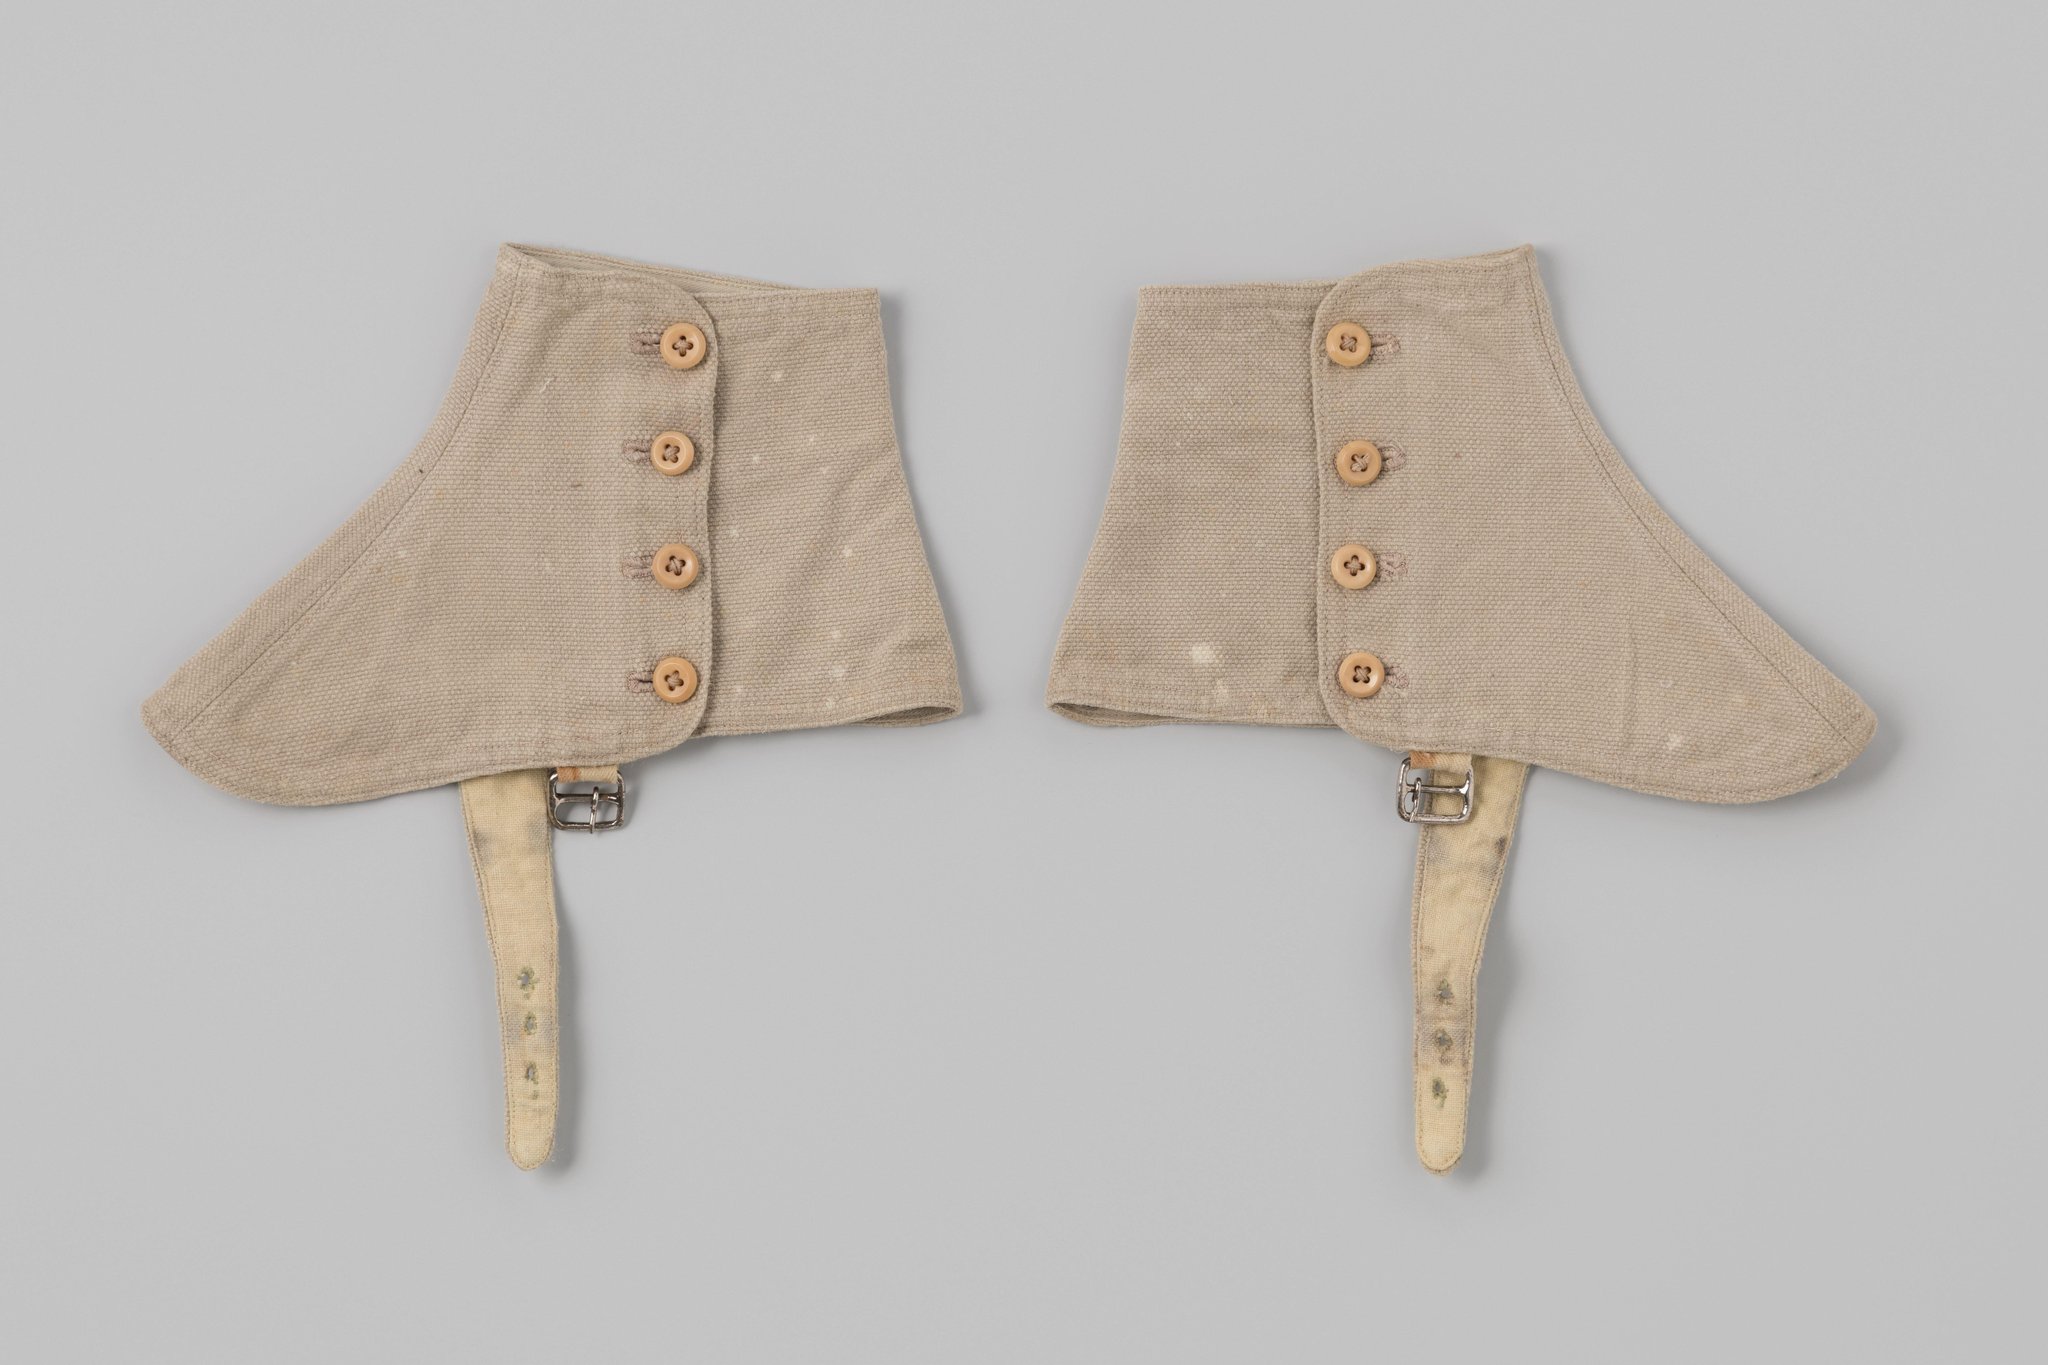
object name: spat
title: Slobkous van zandkleurig linnenkatoen, waarop vier beige knopen en een linnen riem met metalen gesp onder de voet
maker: Anonymous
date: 1900-1930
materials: cotton, metal, plastic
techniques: weave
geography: netherlands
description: Slobkous van zandkleurig linnenkatoen, waarop vier beige knopen en een linnen riem met metalen gesp onder de voet. Ongevoerd maar verstevigd met katoenen biesen.